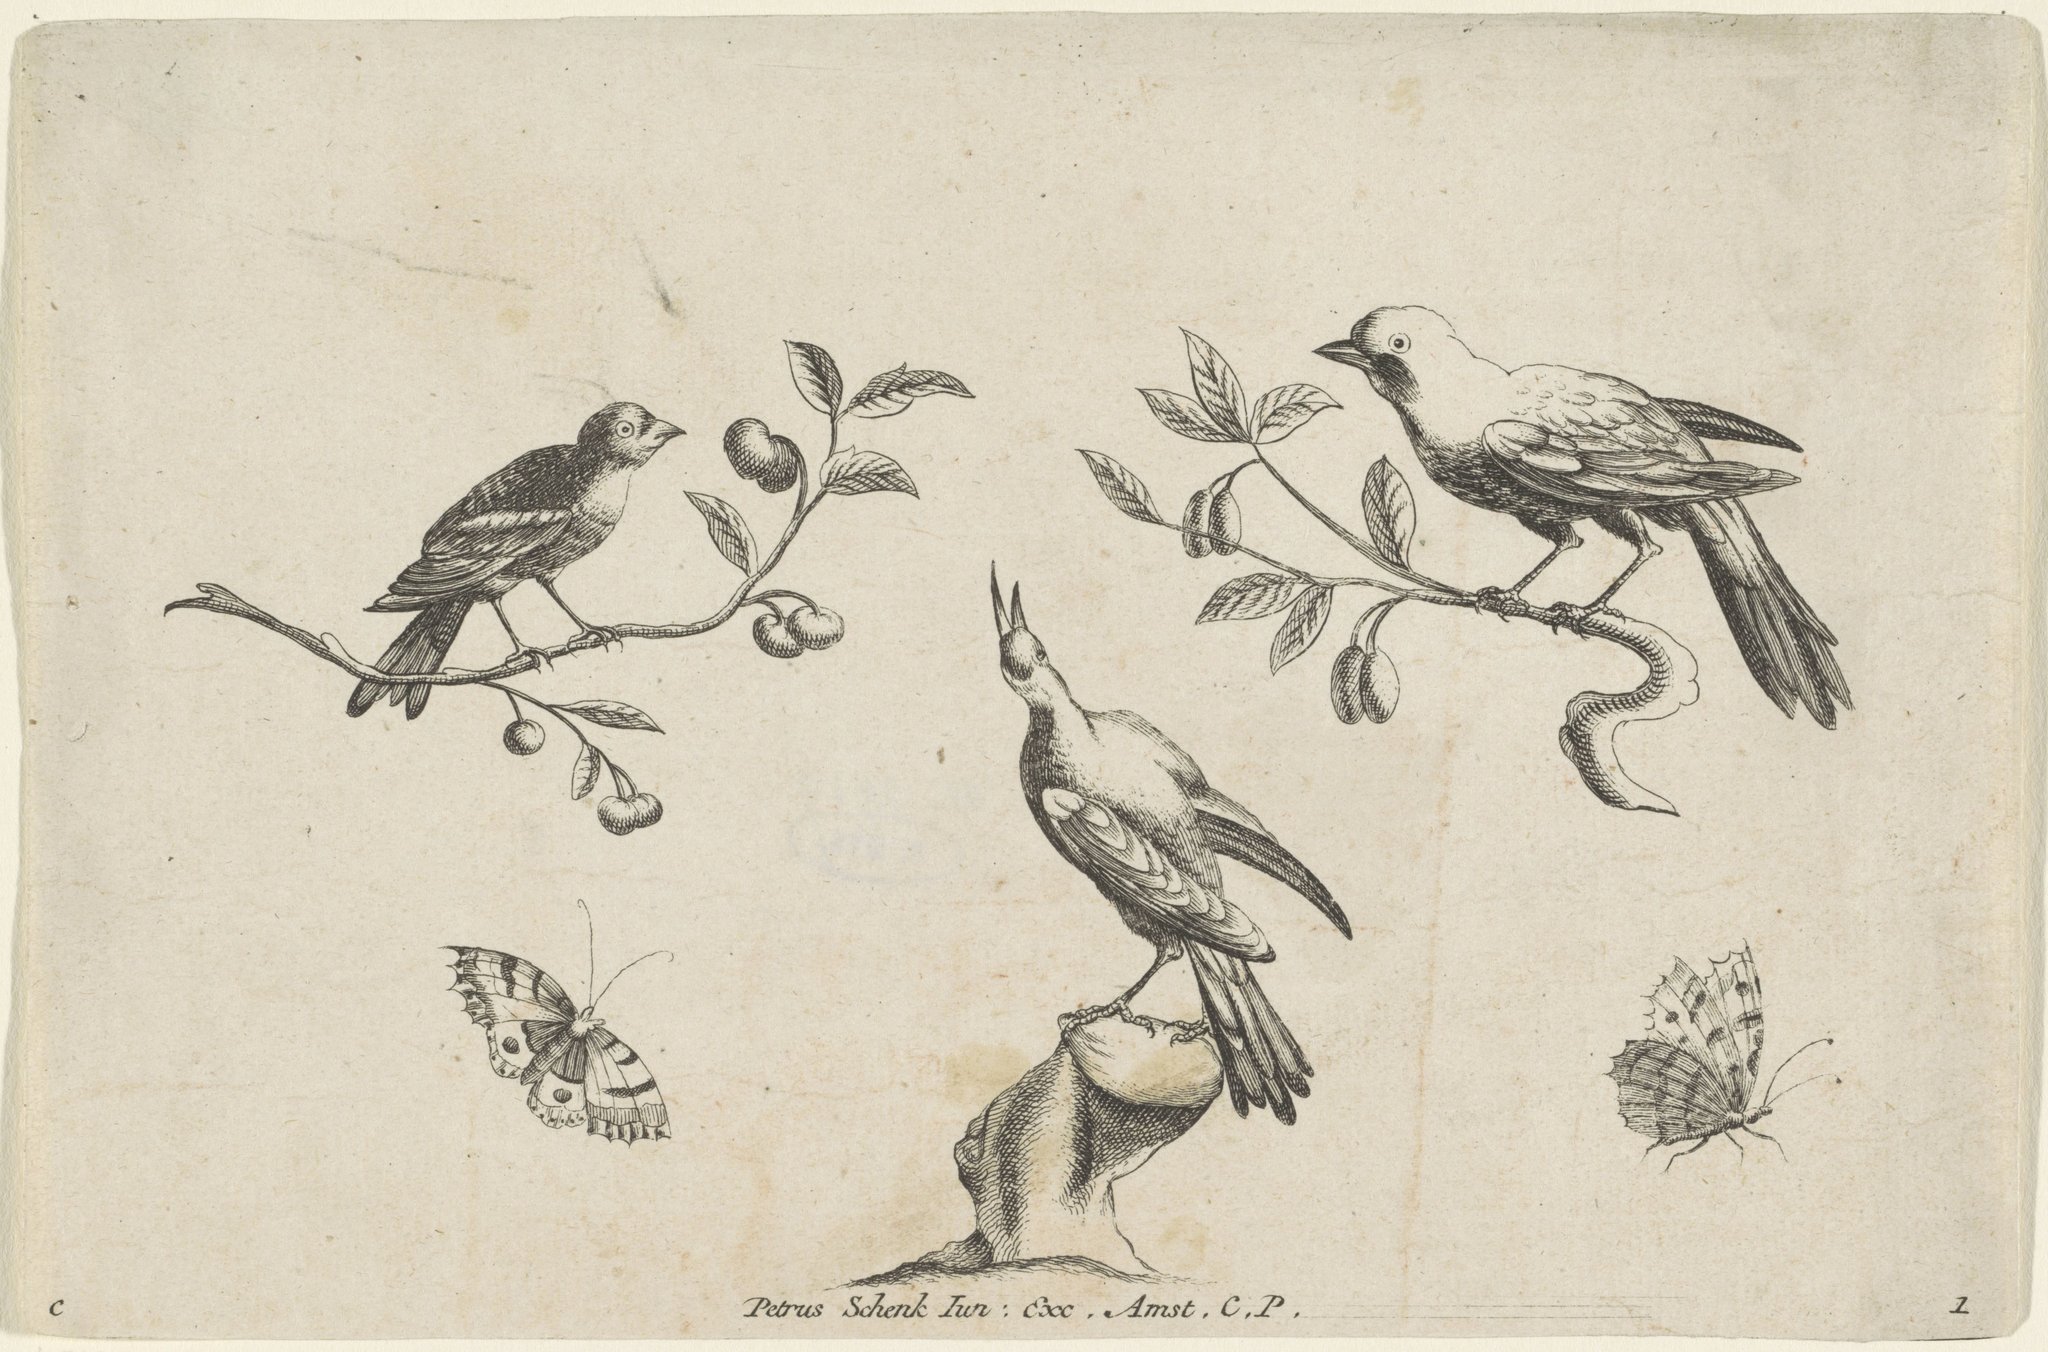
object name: ornament print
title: Verschillende vogels, serie c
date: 1675-1711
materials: paper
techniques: engraving, etching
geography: amsterdam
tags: birds, insects: butterfly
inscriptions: collector's mark: Lugt 2228